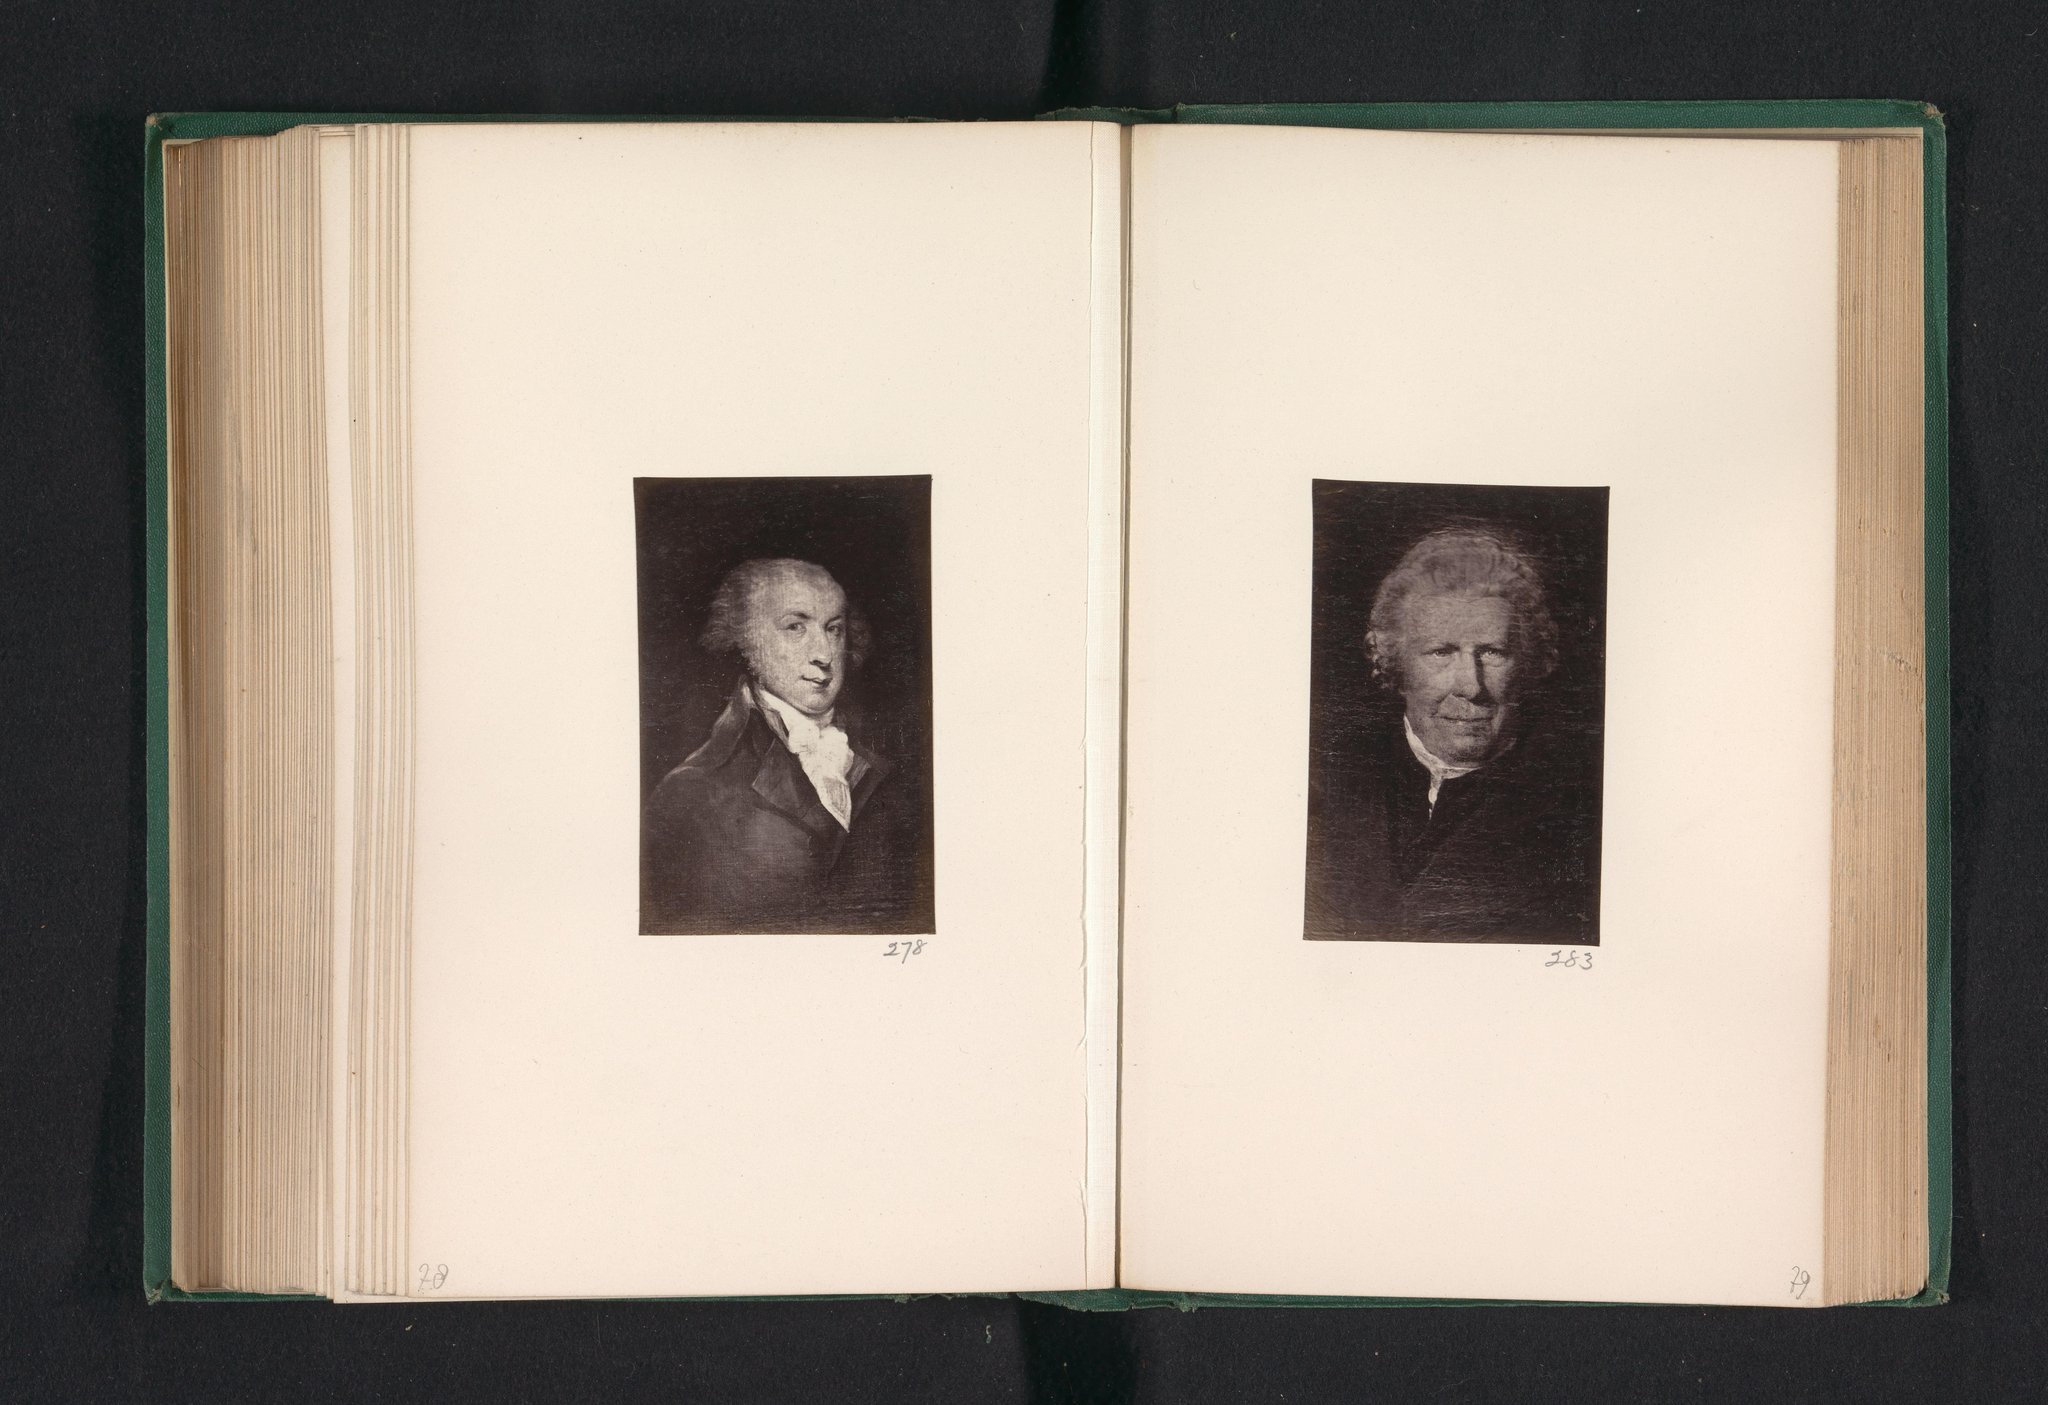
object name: page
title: Fotoreproductie van een schilderij, voorstellende een portret van Robert Hamilton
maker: thomas annan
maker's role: fotograaf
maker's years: 1829-1887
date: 1863-1868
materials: photographic support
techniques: albumen print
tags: historical persons (portraits and scenes from the life) (+ (full) bust portrait)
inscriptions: number: ‘276’